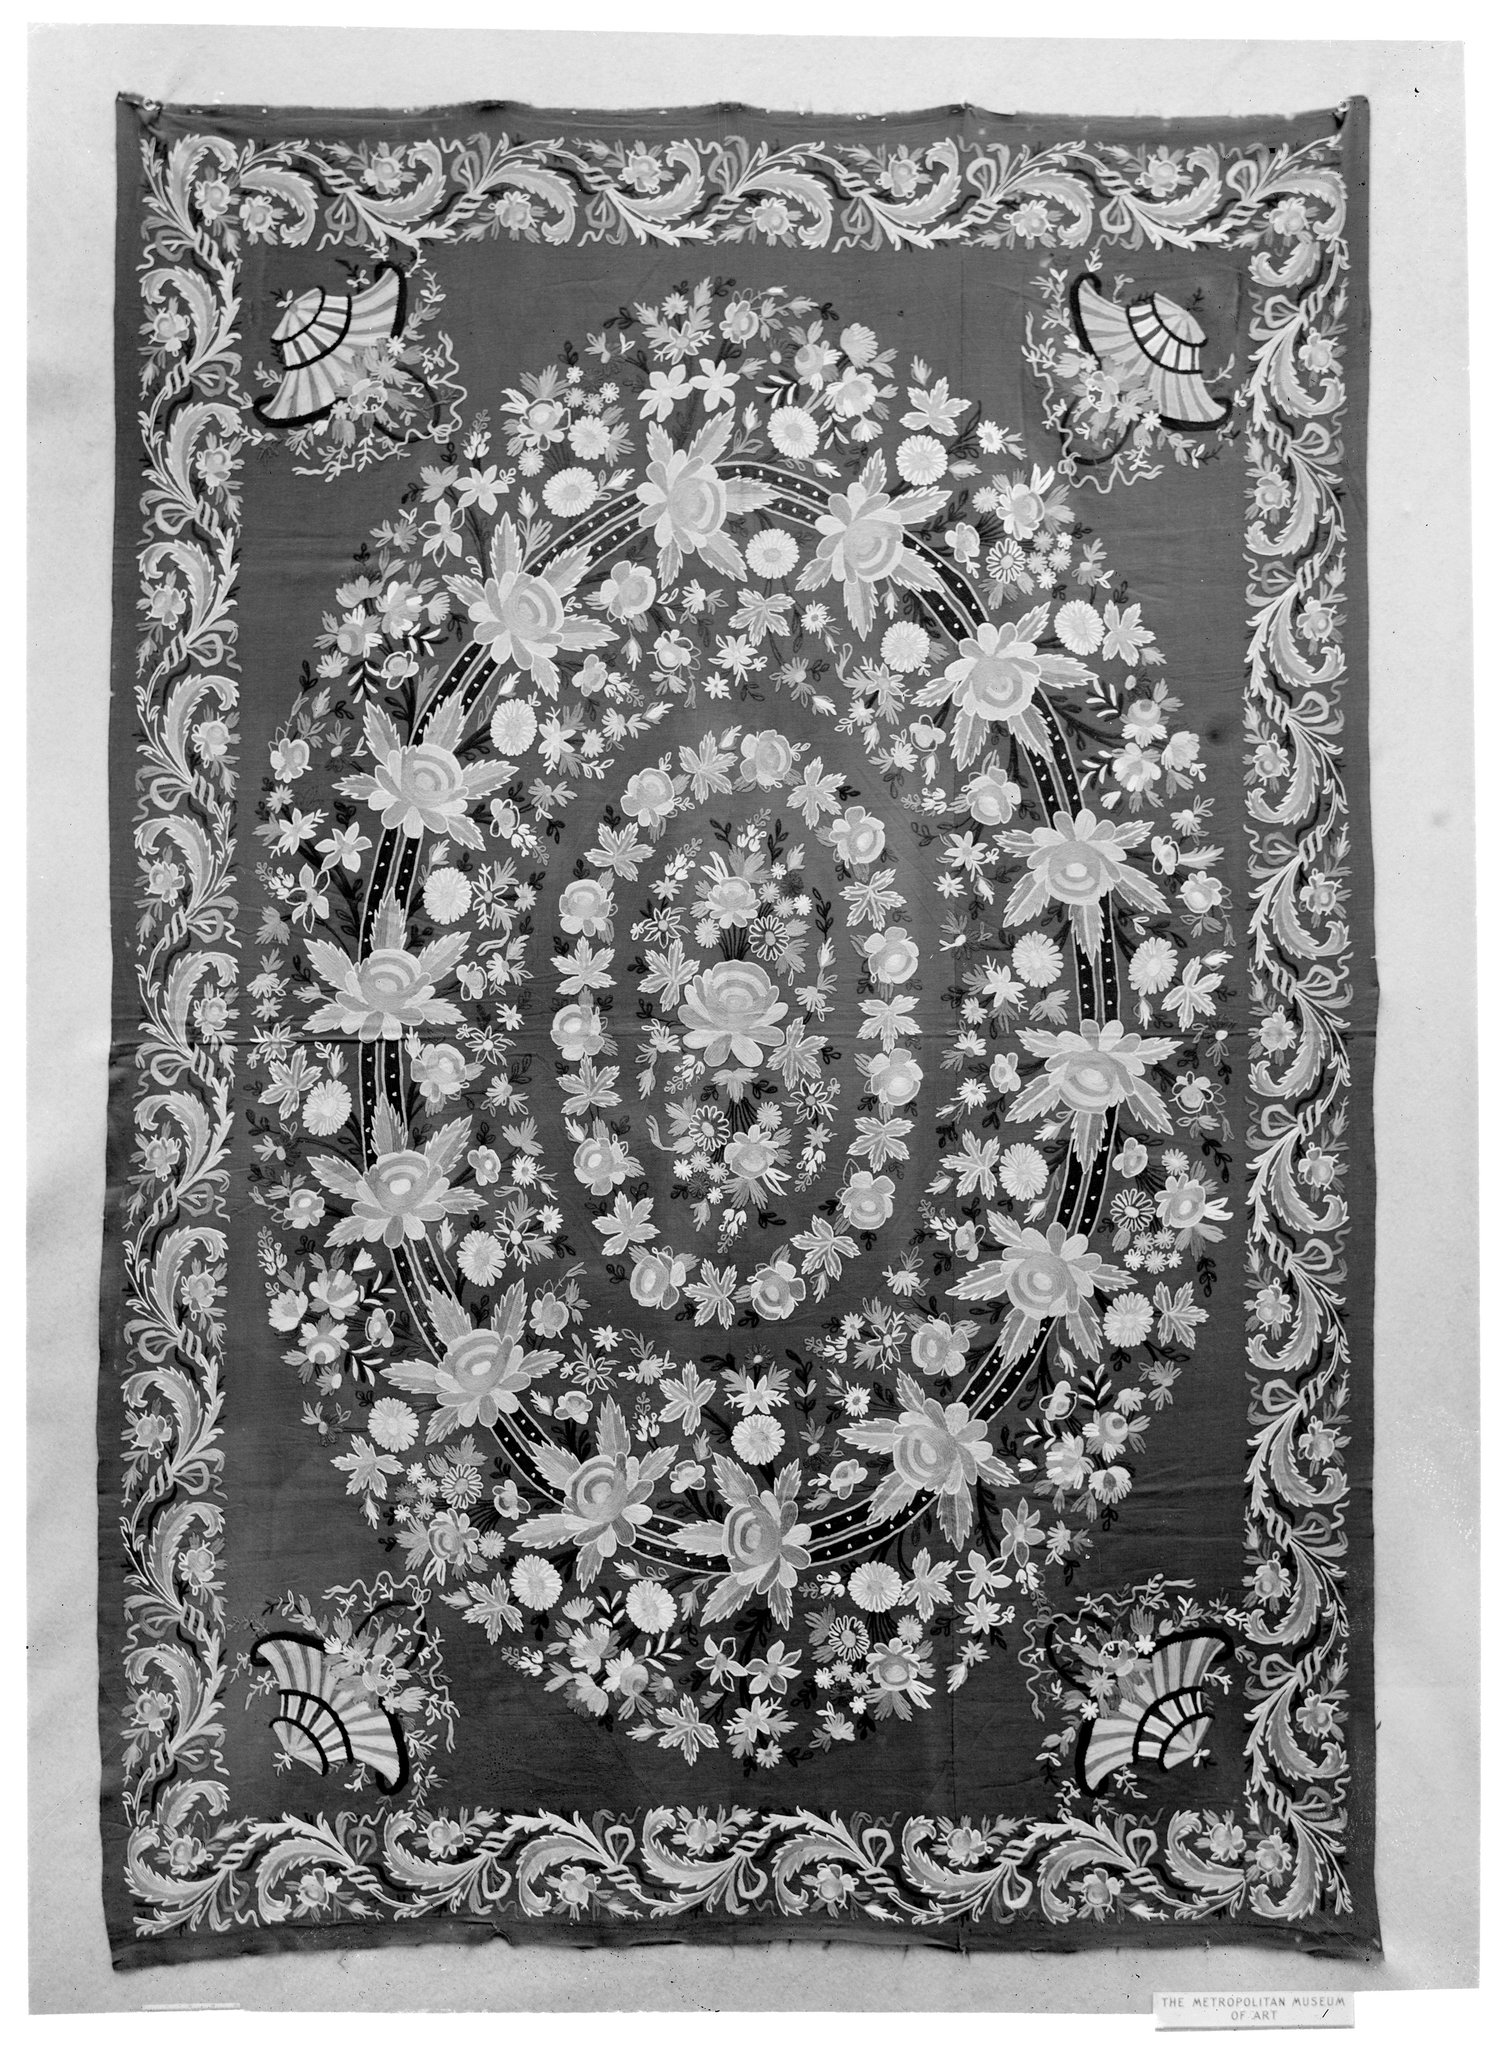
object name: cover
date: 1801-1833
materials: metal thread, silk, wool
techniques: embroidery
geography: turkey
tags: flowers